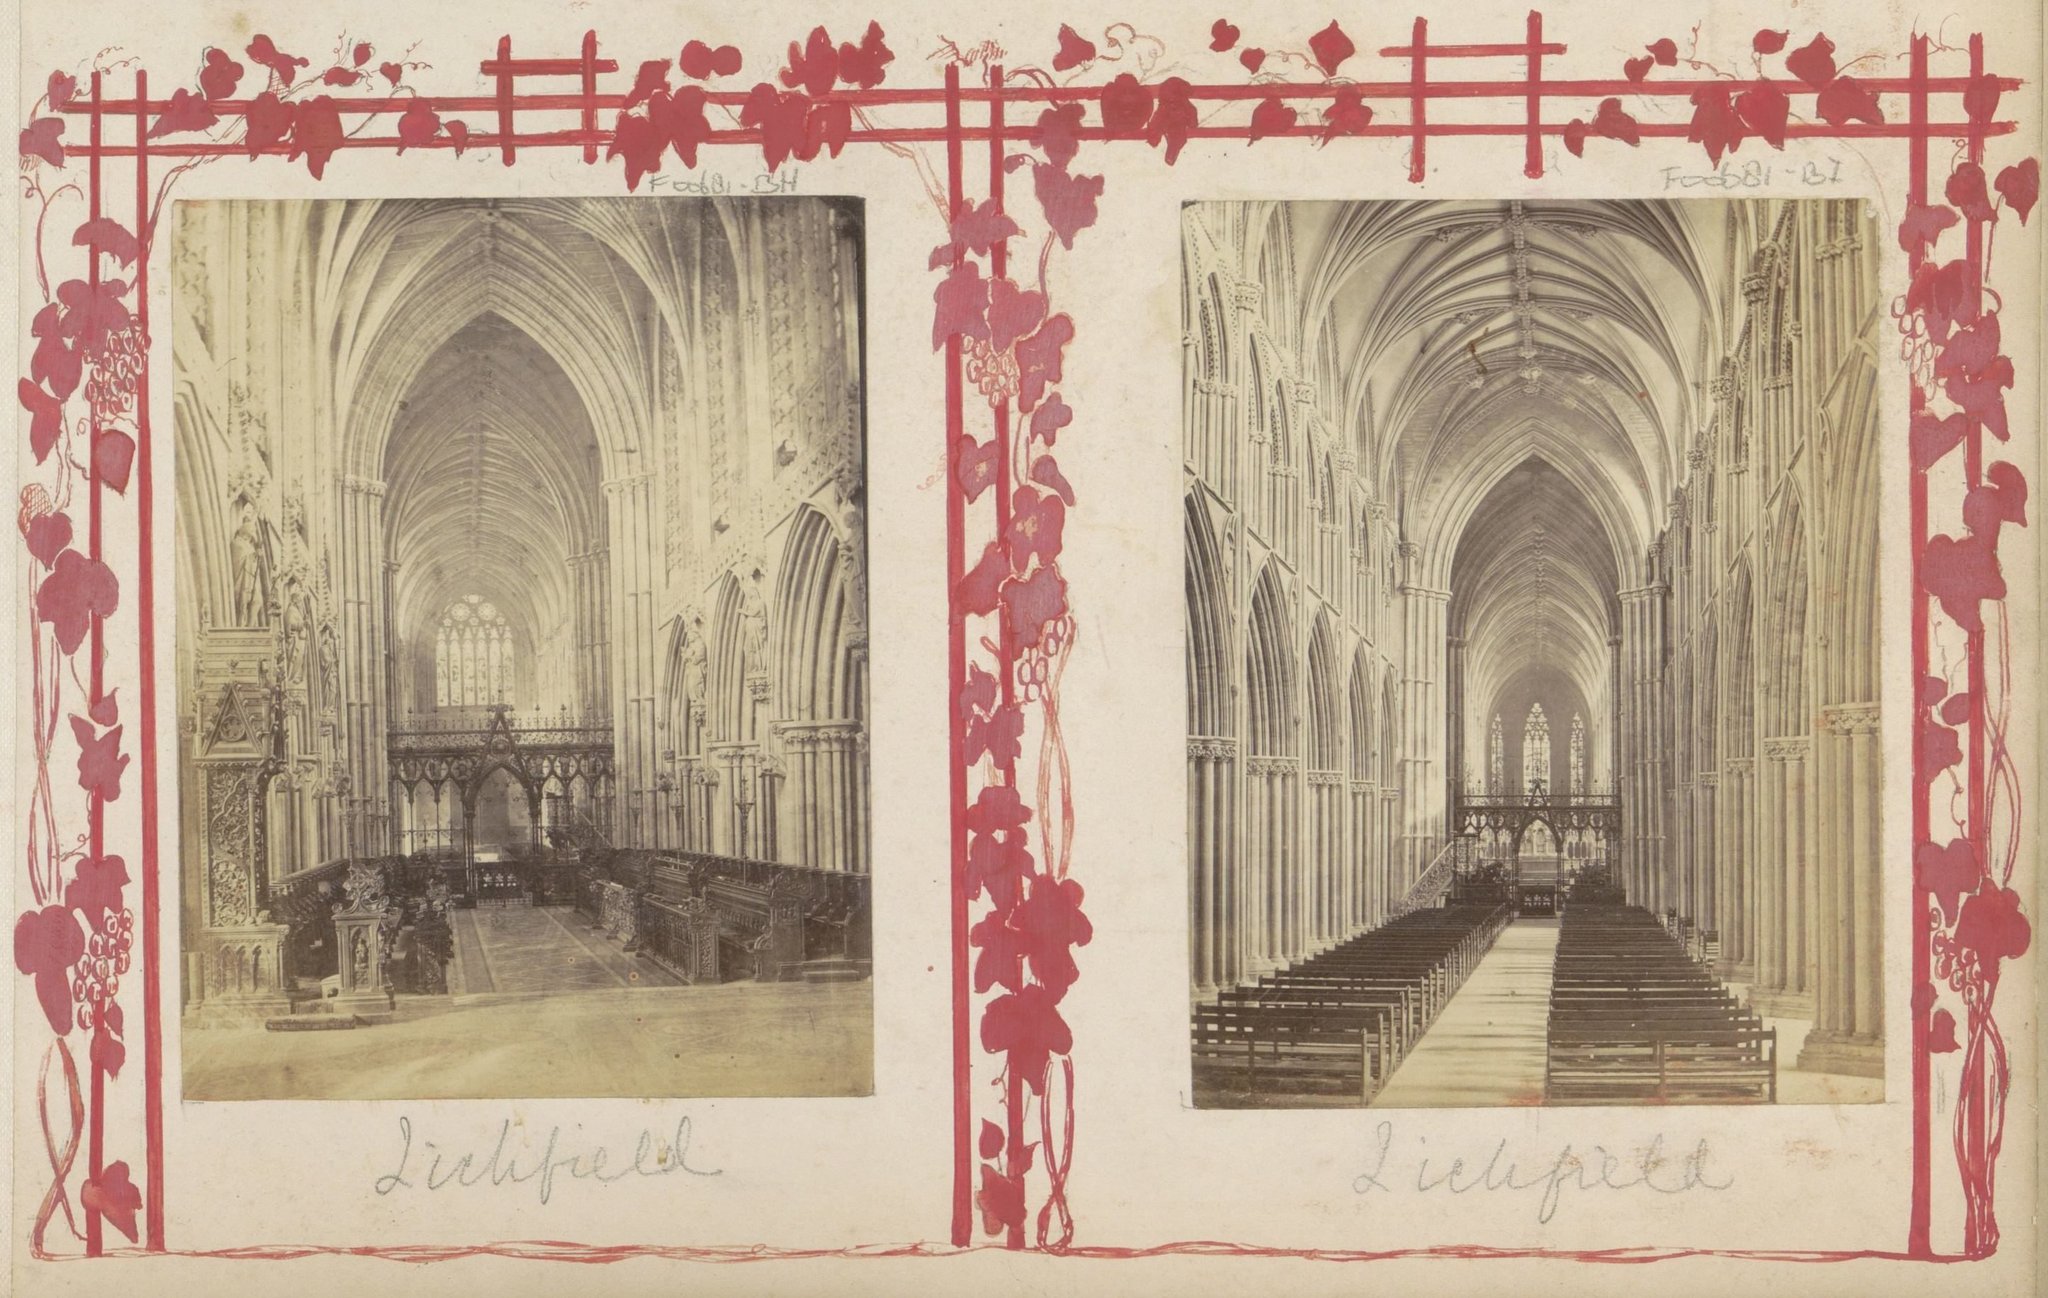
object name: photograph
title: Schip en koorhek van de kathedraal van Lichfield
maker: Anonymous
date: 1850-1870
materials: paper, photographic support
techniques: albumen print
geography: lichfield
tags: rood-screen, choir-screen; iconostasis, parts of church interior: nave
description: Onderdeel van Album met foto's van bezienswaardigheden en landschappen in Engeland en van kunst.